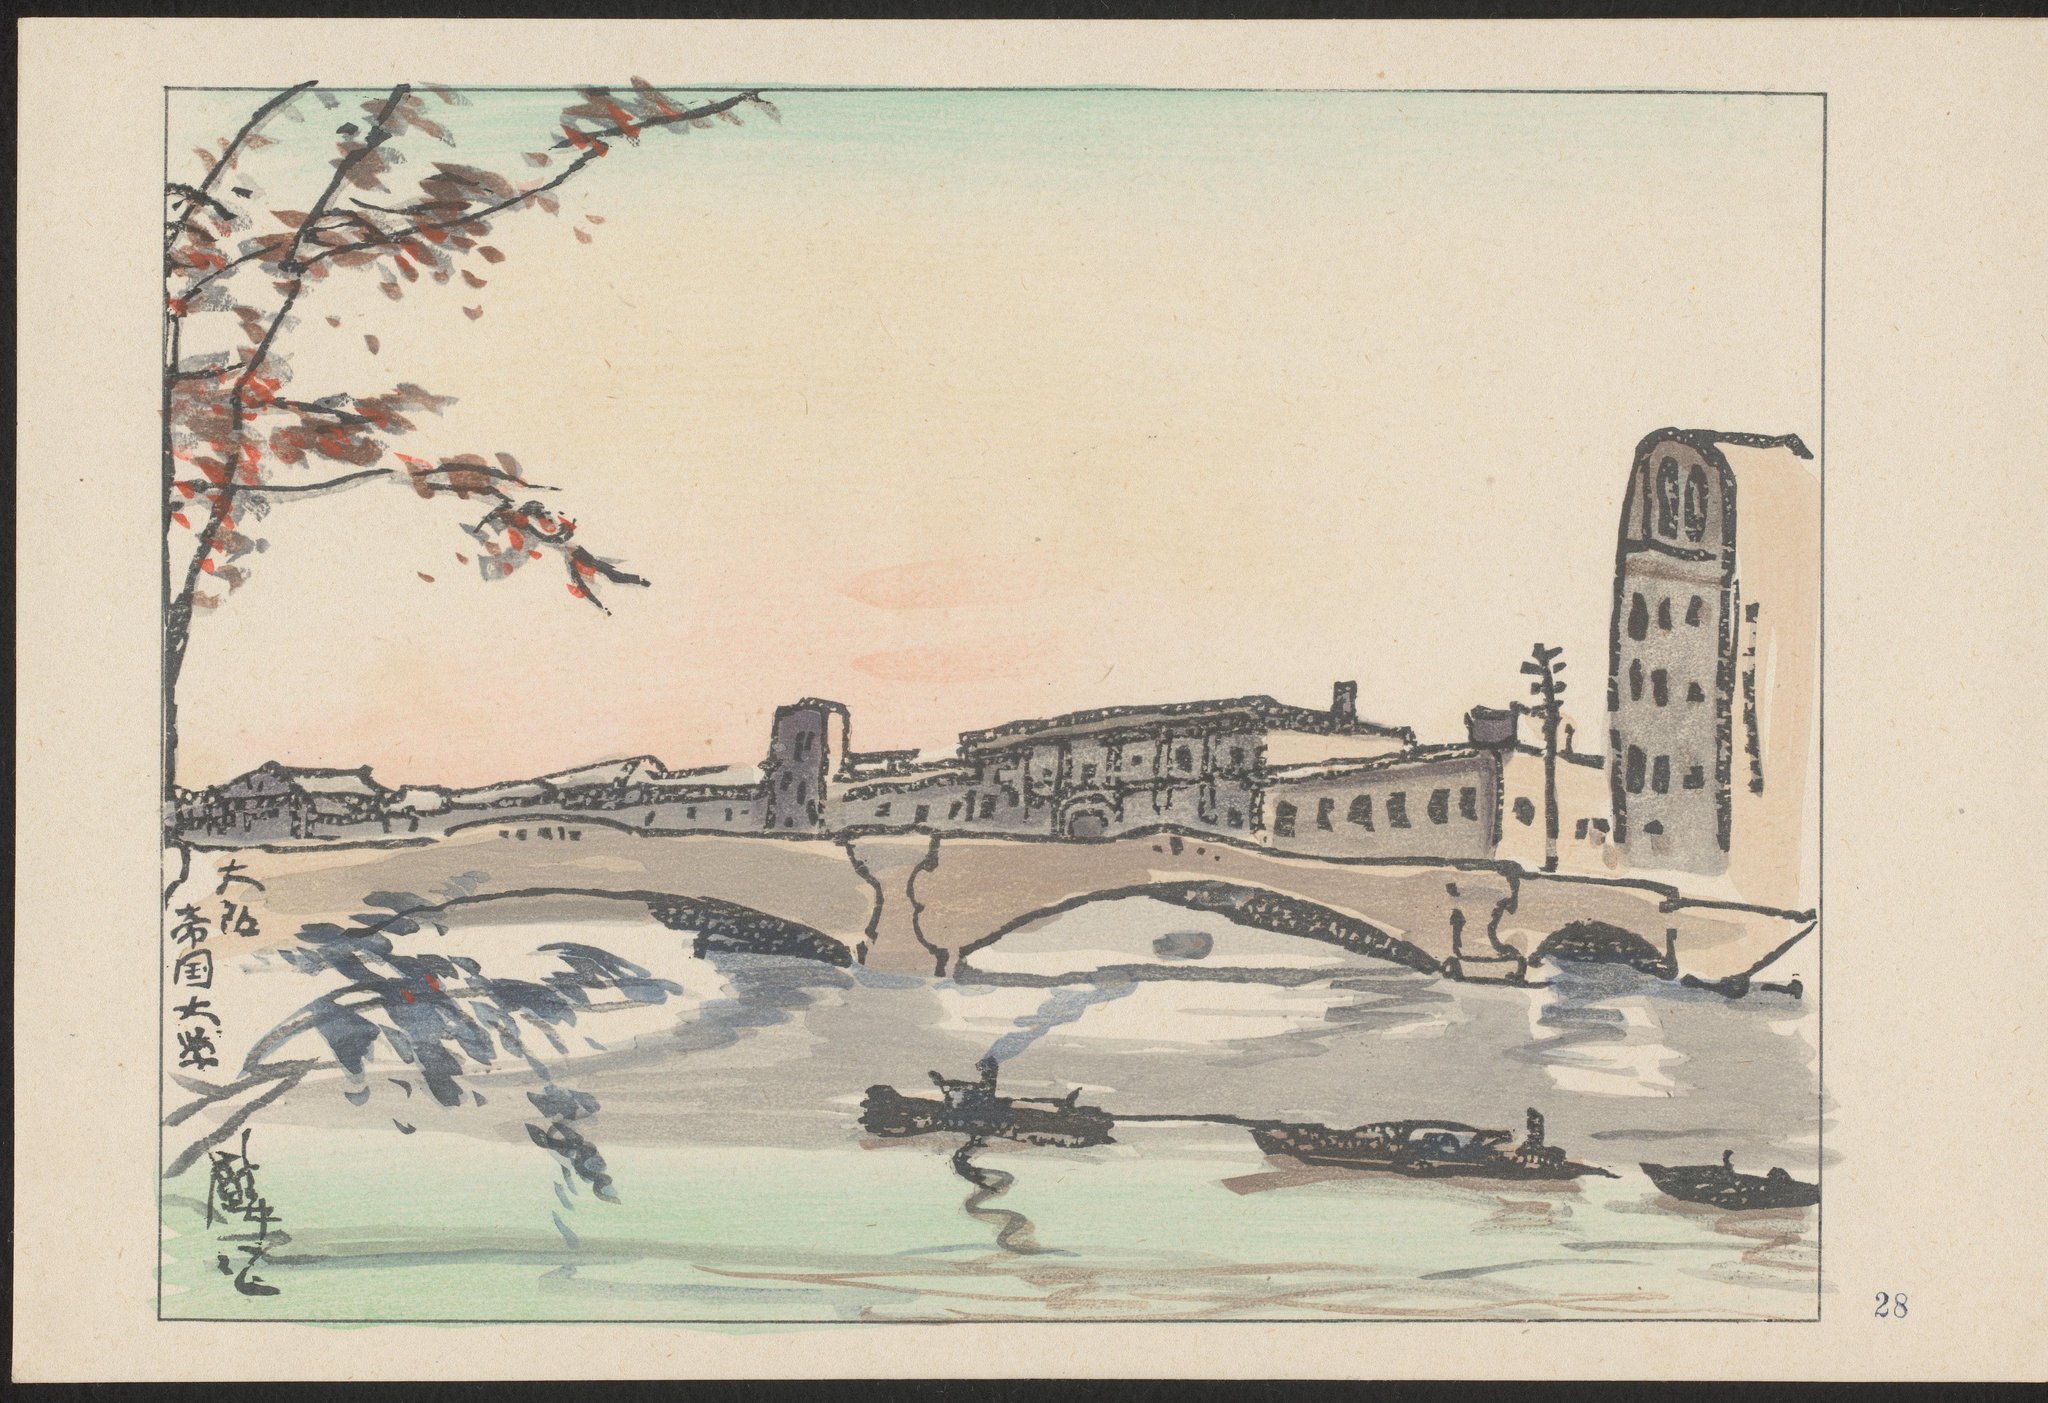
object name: print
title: Osaka Imperial University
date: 1947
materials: paper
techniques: woodcut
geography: japan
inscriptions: date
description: Gezicht op de campus van de Keizerlijke Universiteit van Osaka in de wijk Nakanoshima.